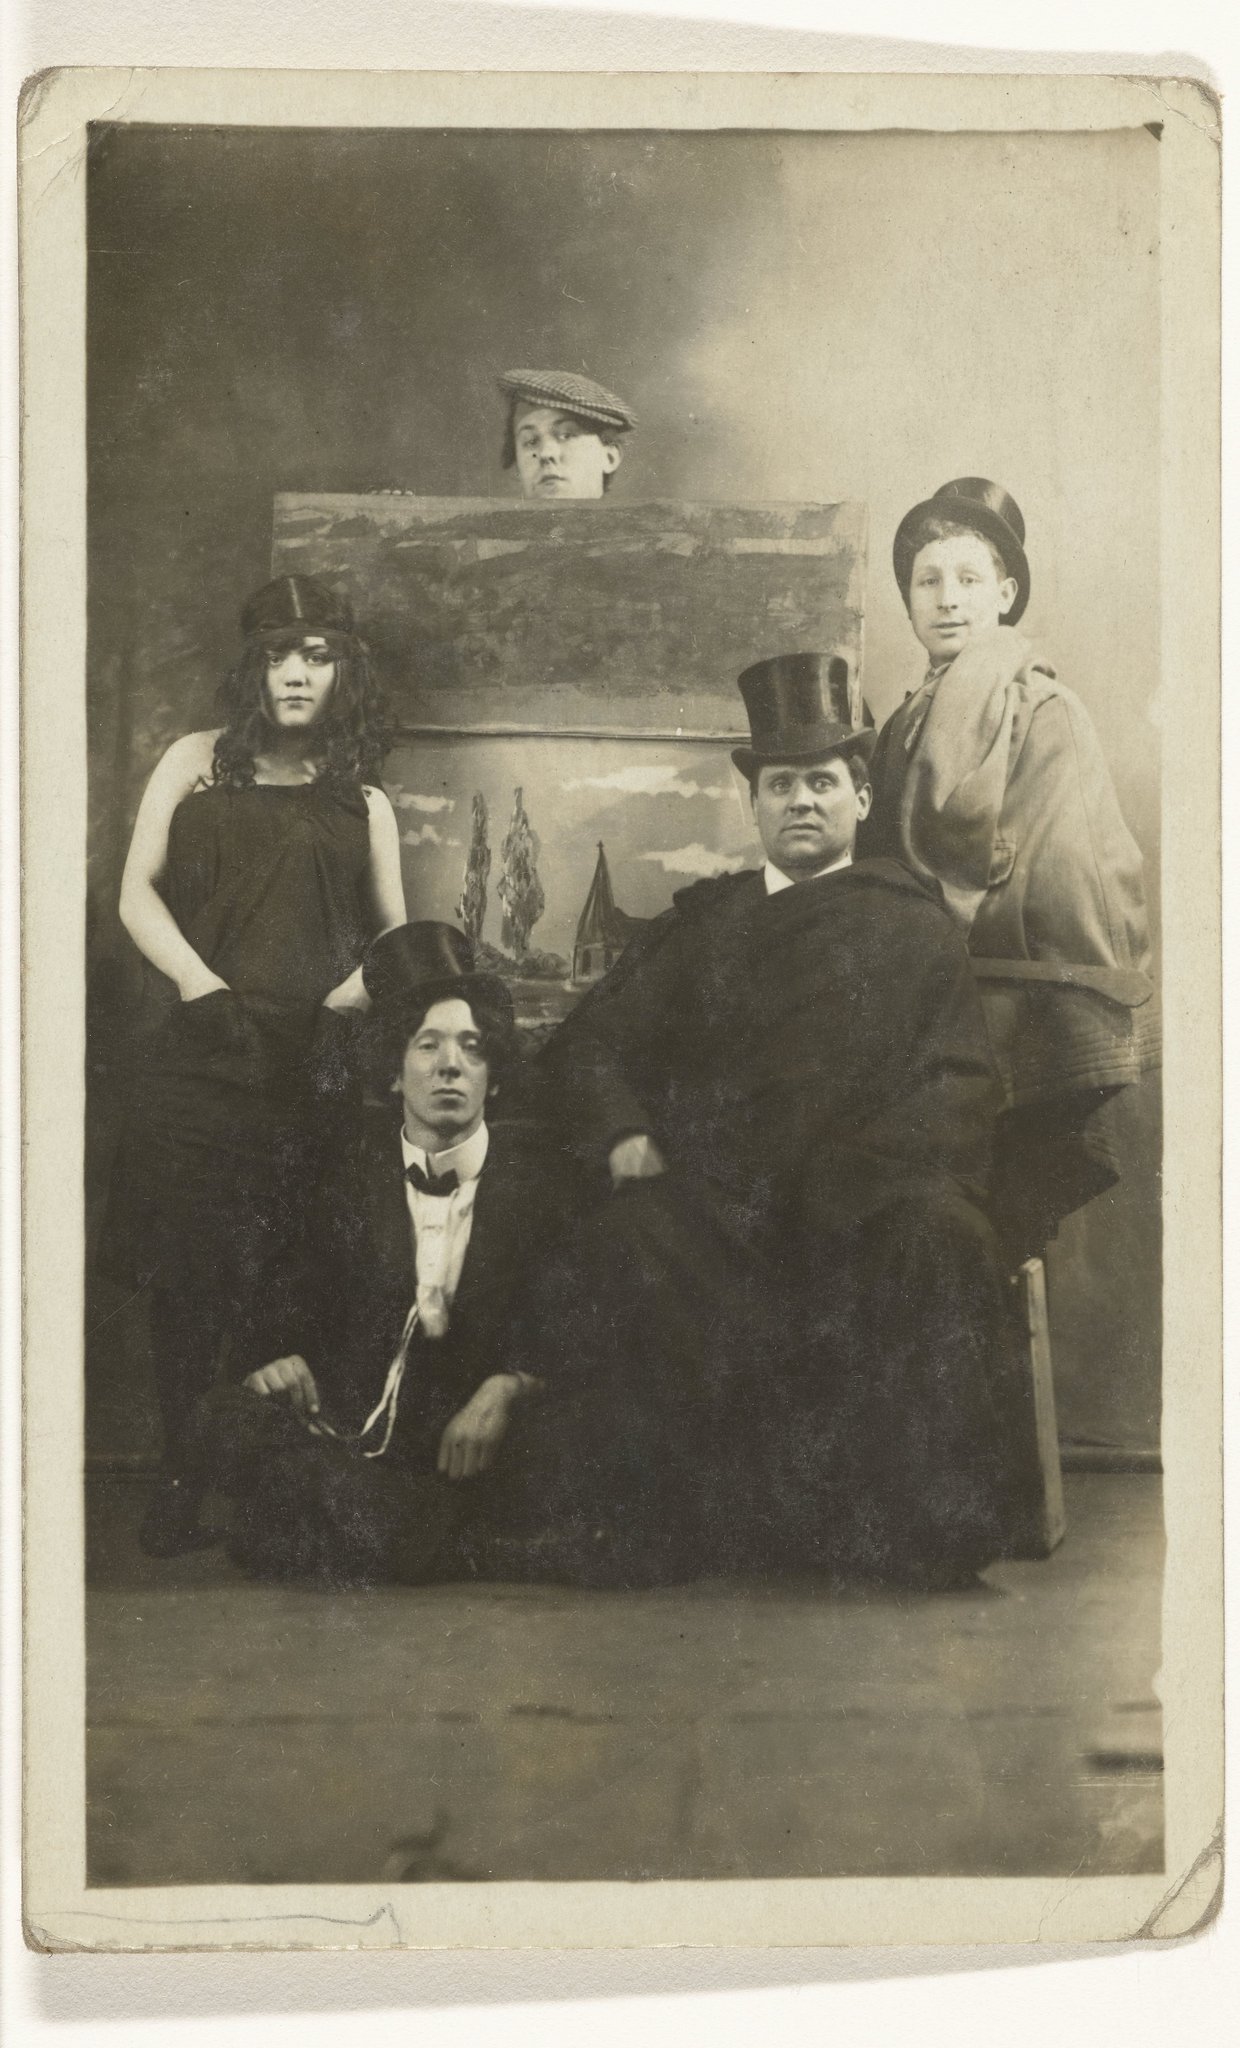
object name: ansichtkaart, prentbriefkaart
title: Annie Eman, Röntgen, Breslau en Jaeger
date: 1910-1940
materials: cardboard, paper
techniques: gelatin silver print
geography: amsterdam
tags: anonymous historical persons portrayed in a group, in a group-portrait